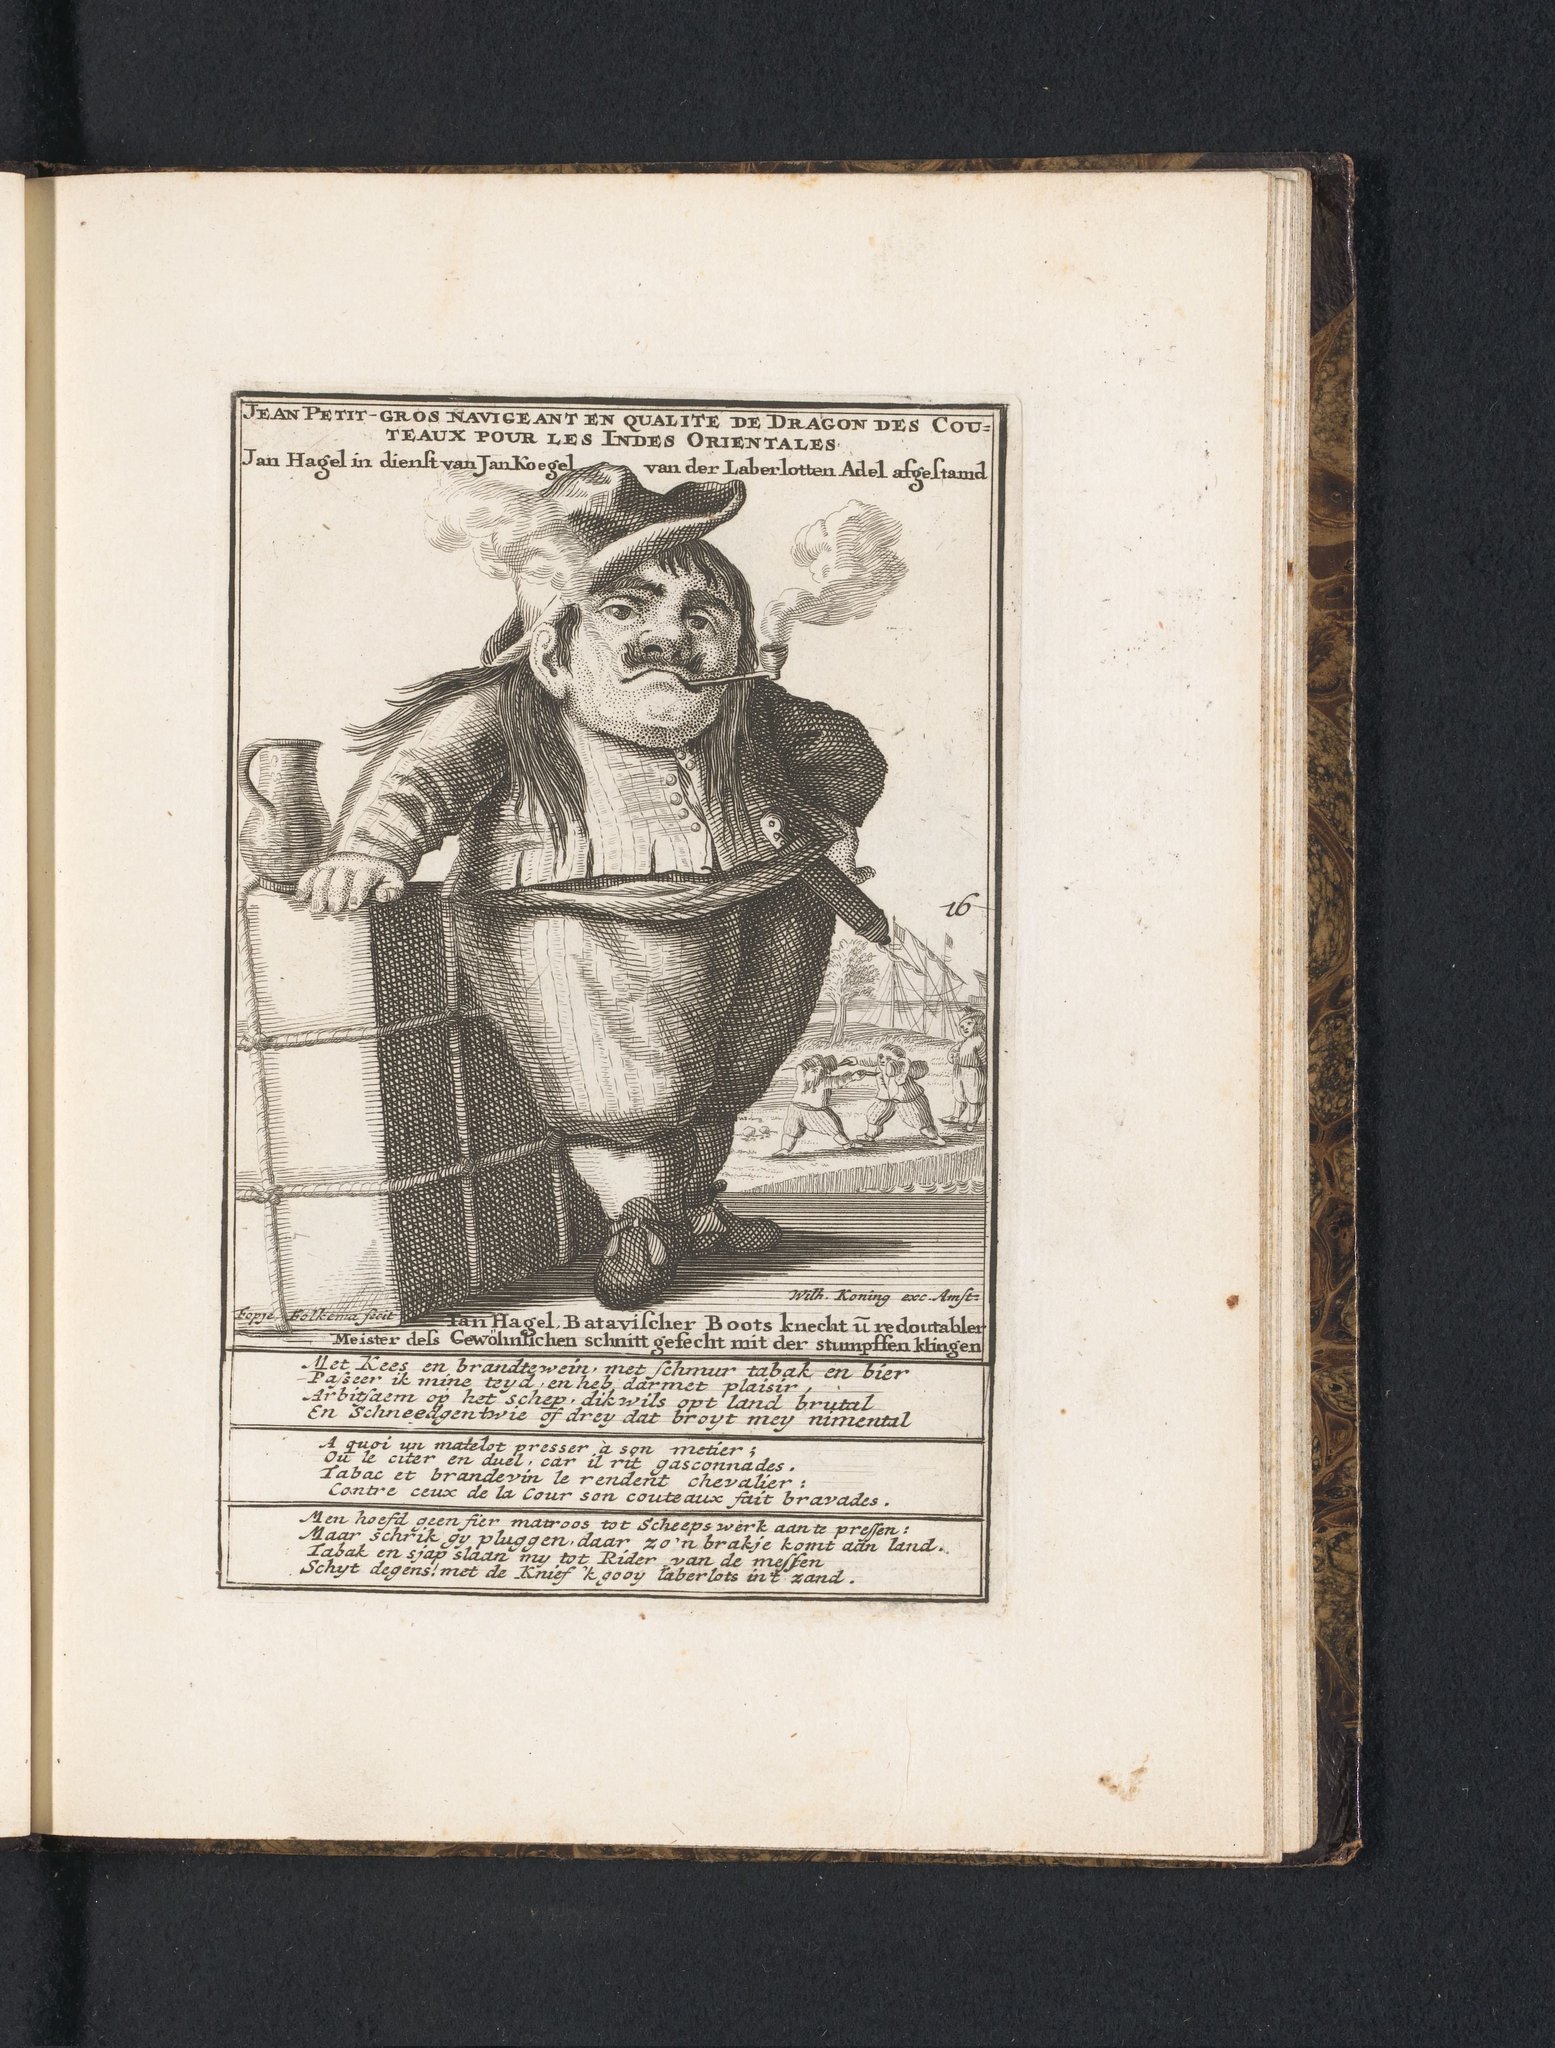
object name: print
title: Jean Petit-Gros navigeant en qualite de Dragon des Couteaux pour les Indes Orientales / Jan Hagel in dienst van Jan Koegel van der Laberlotten Adel afgestamd / Tan Hagel, Batavischer Boots knecht, u. redoutabler Meister dess Gewöhnlichen schnitt gefecht mit der stumpffen klingen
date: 1718-1720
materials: paper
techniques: etching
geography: northern netherlands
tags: caricatures (human types), little people, seaman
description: De kleine mens Jan Hagel als een Hollandse bootsknecht. In het onderschrift verzen in het Nederlands en Frans. Genummerd rechts midden: 16. Onderdeel van de tweede Nederlandse gebonden uitgave uit 1720 (en gerelateerd aan de Windhandel in dat jaar) van een serie karikaturen van kleine mensen, bekend als Het Dwergentooneel.